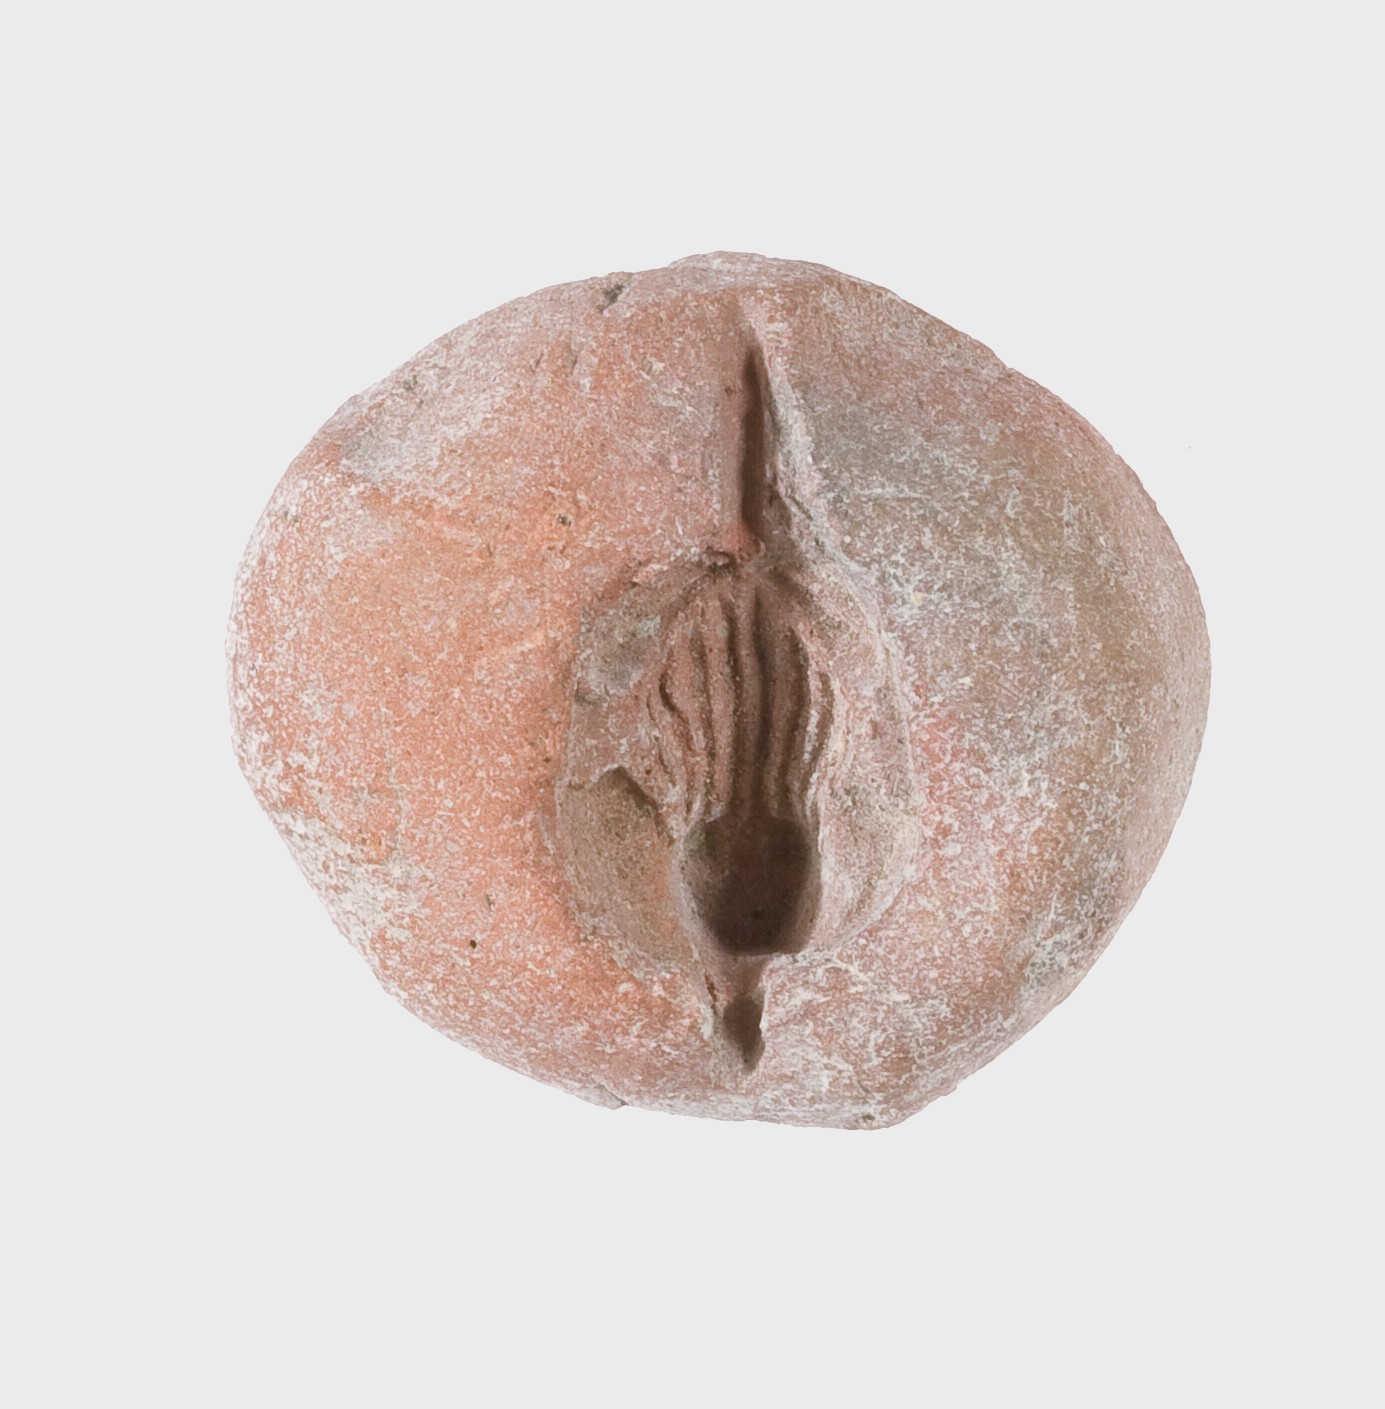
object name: mold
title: Frog Mold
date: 1390-1352 BCE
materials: pottery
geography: egypt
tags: frogs